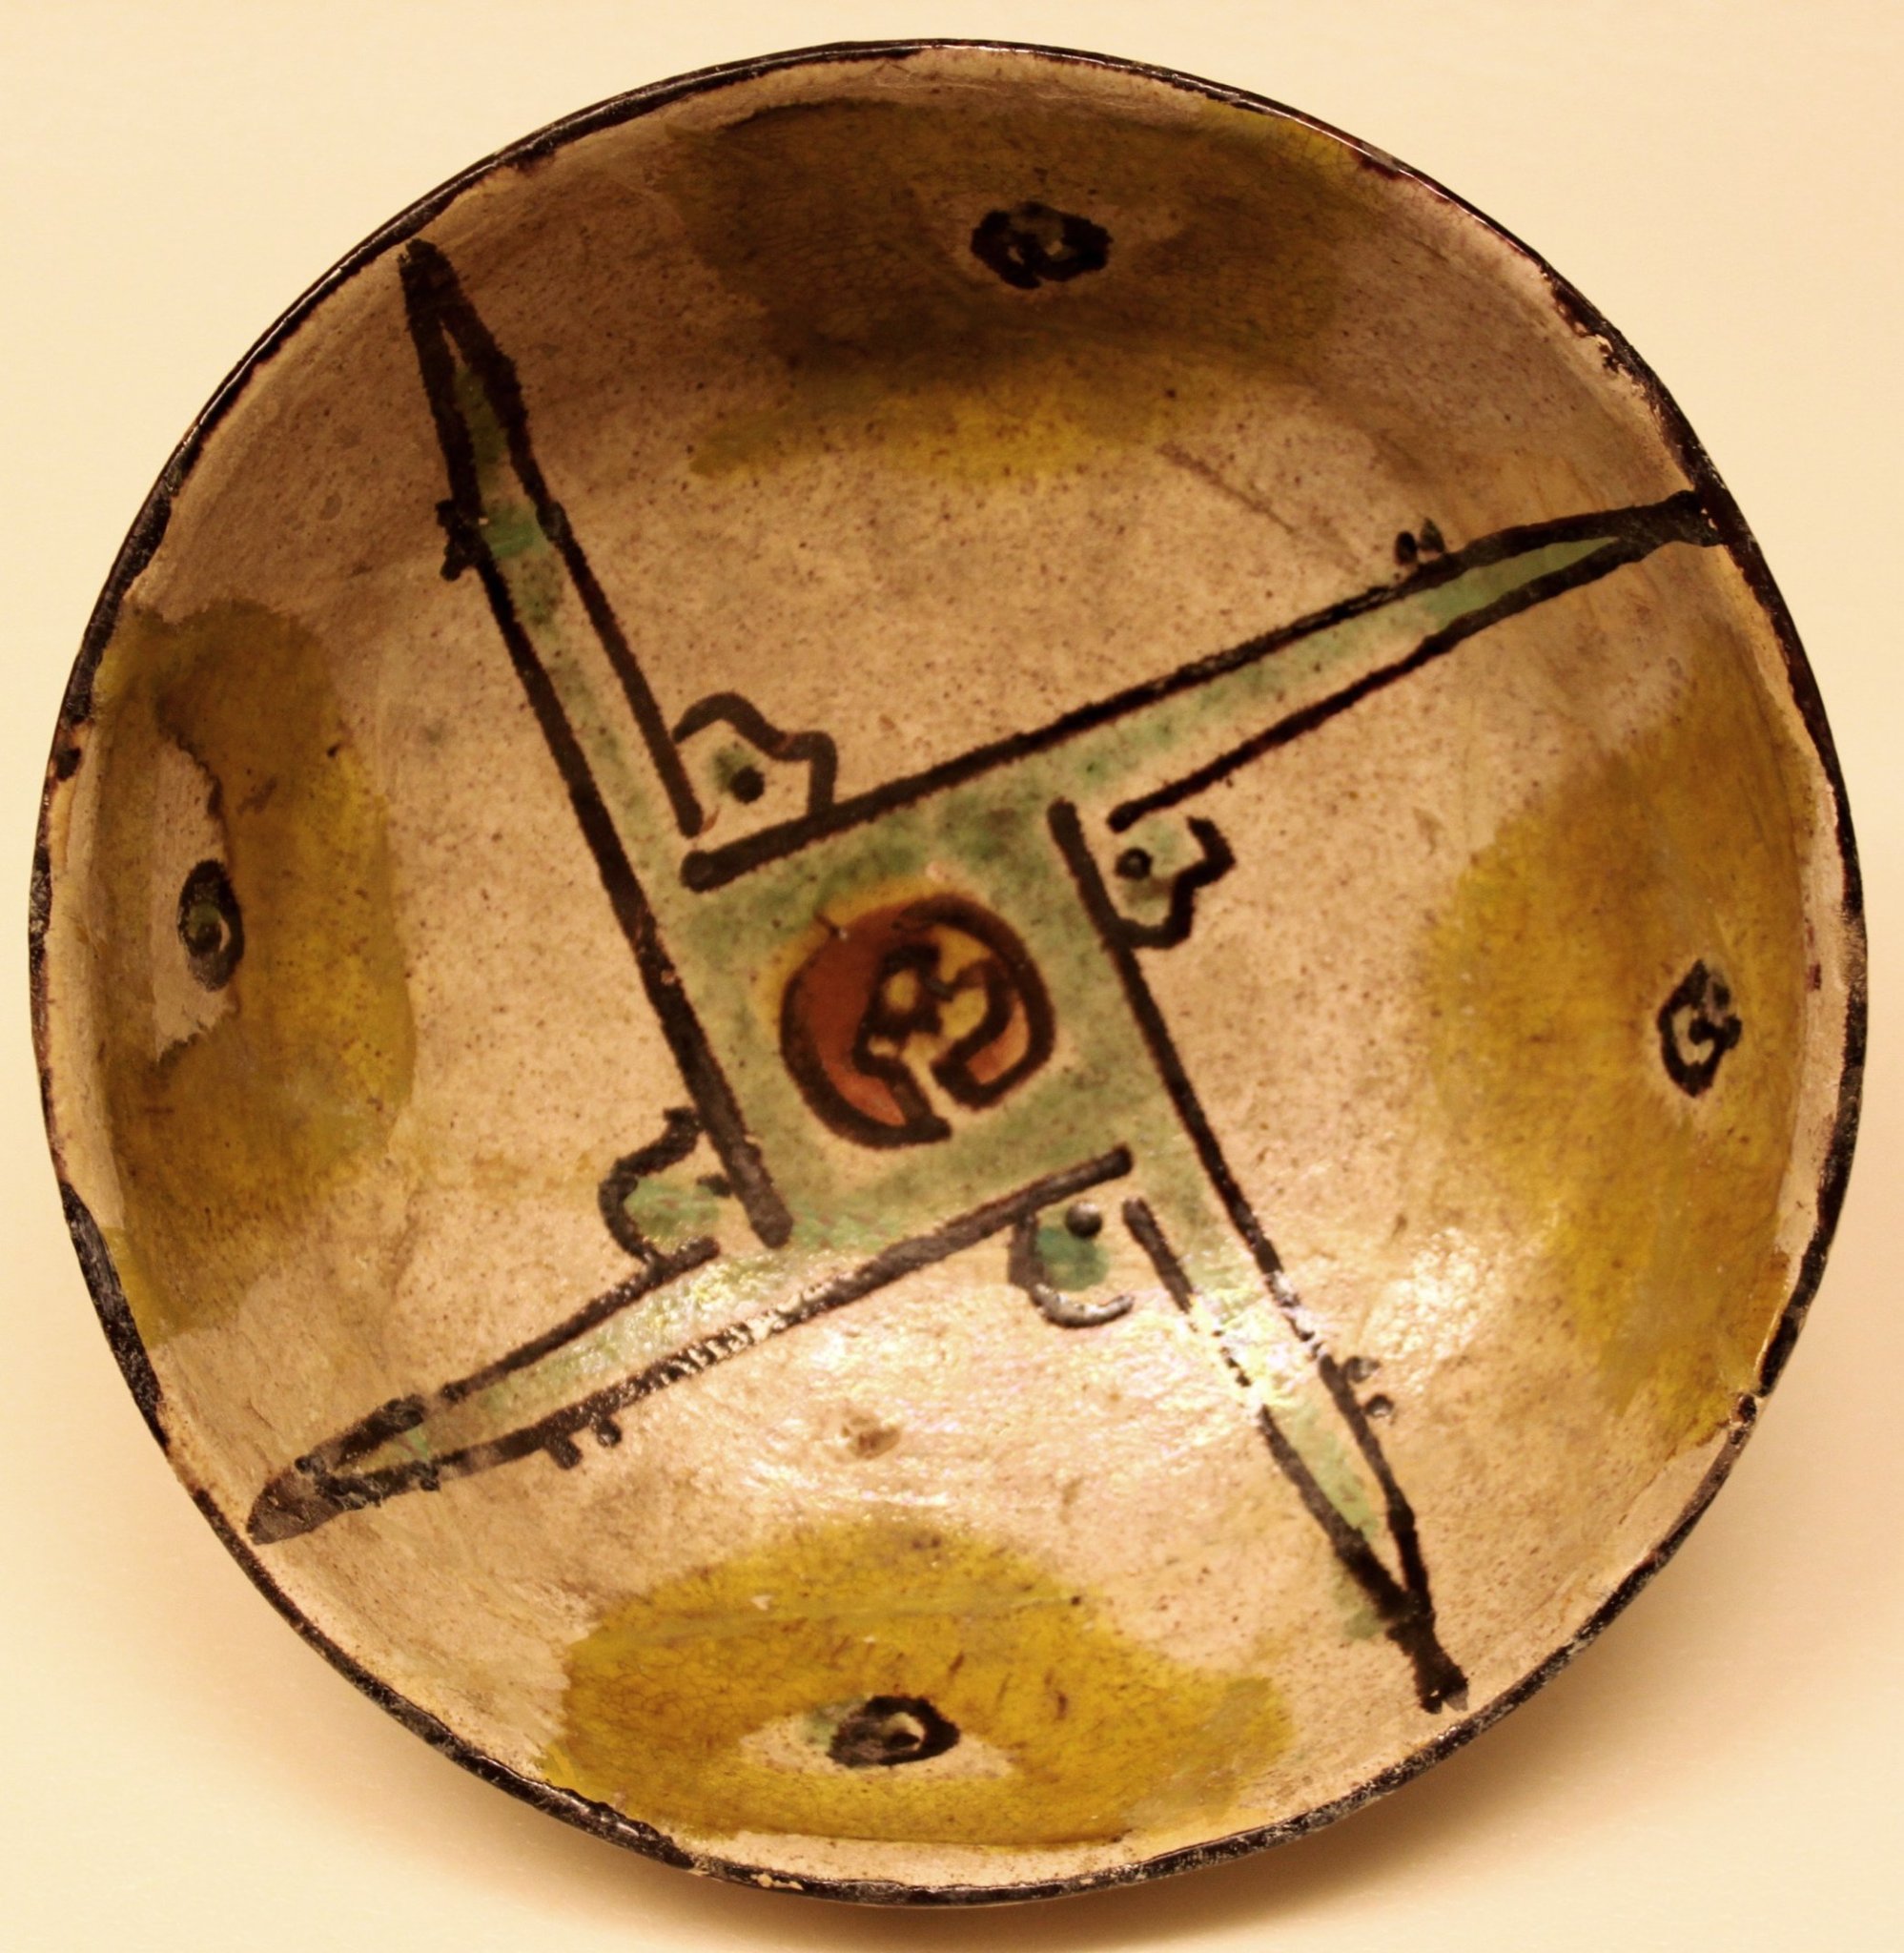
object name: bowl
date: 901-1000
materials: earthenware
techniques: painting, underglaze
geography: iran